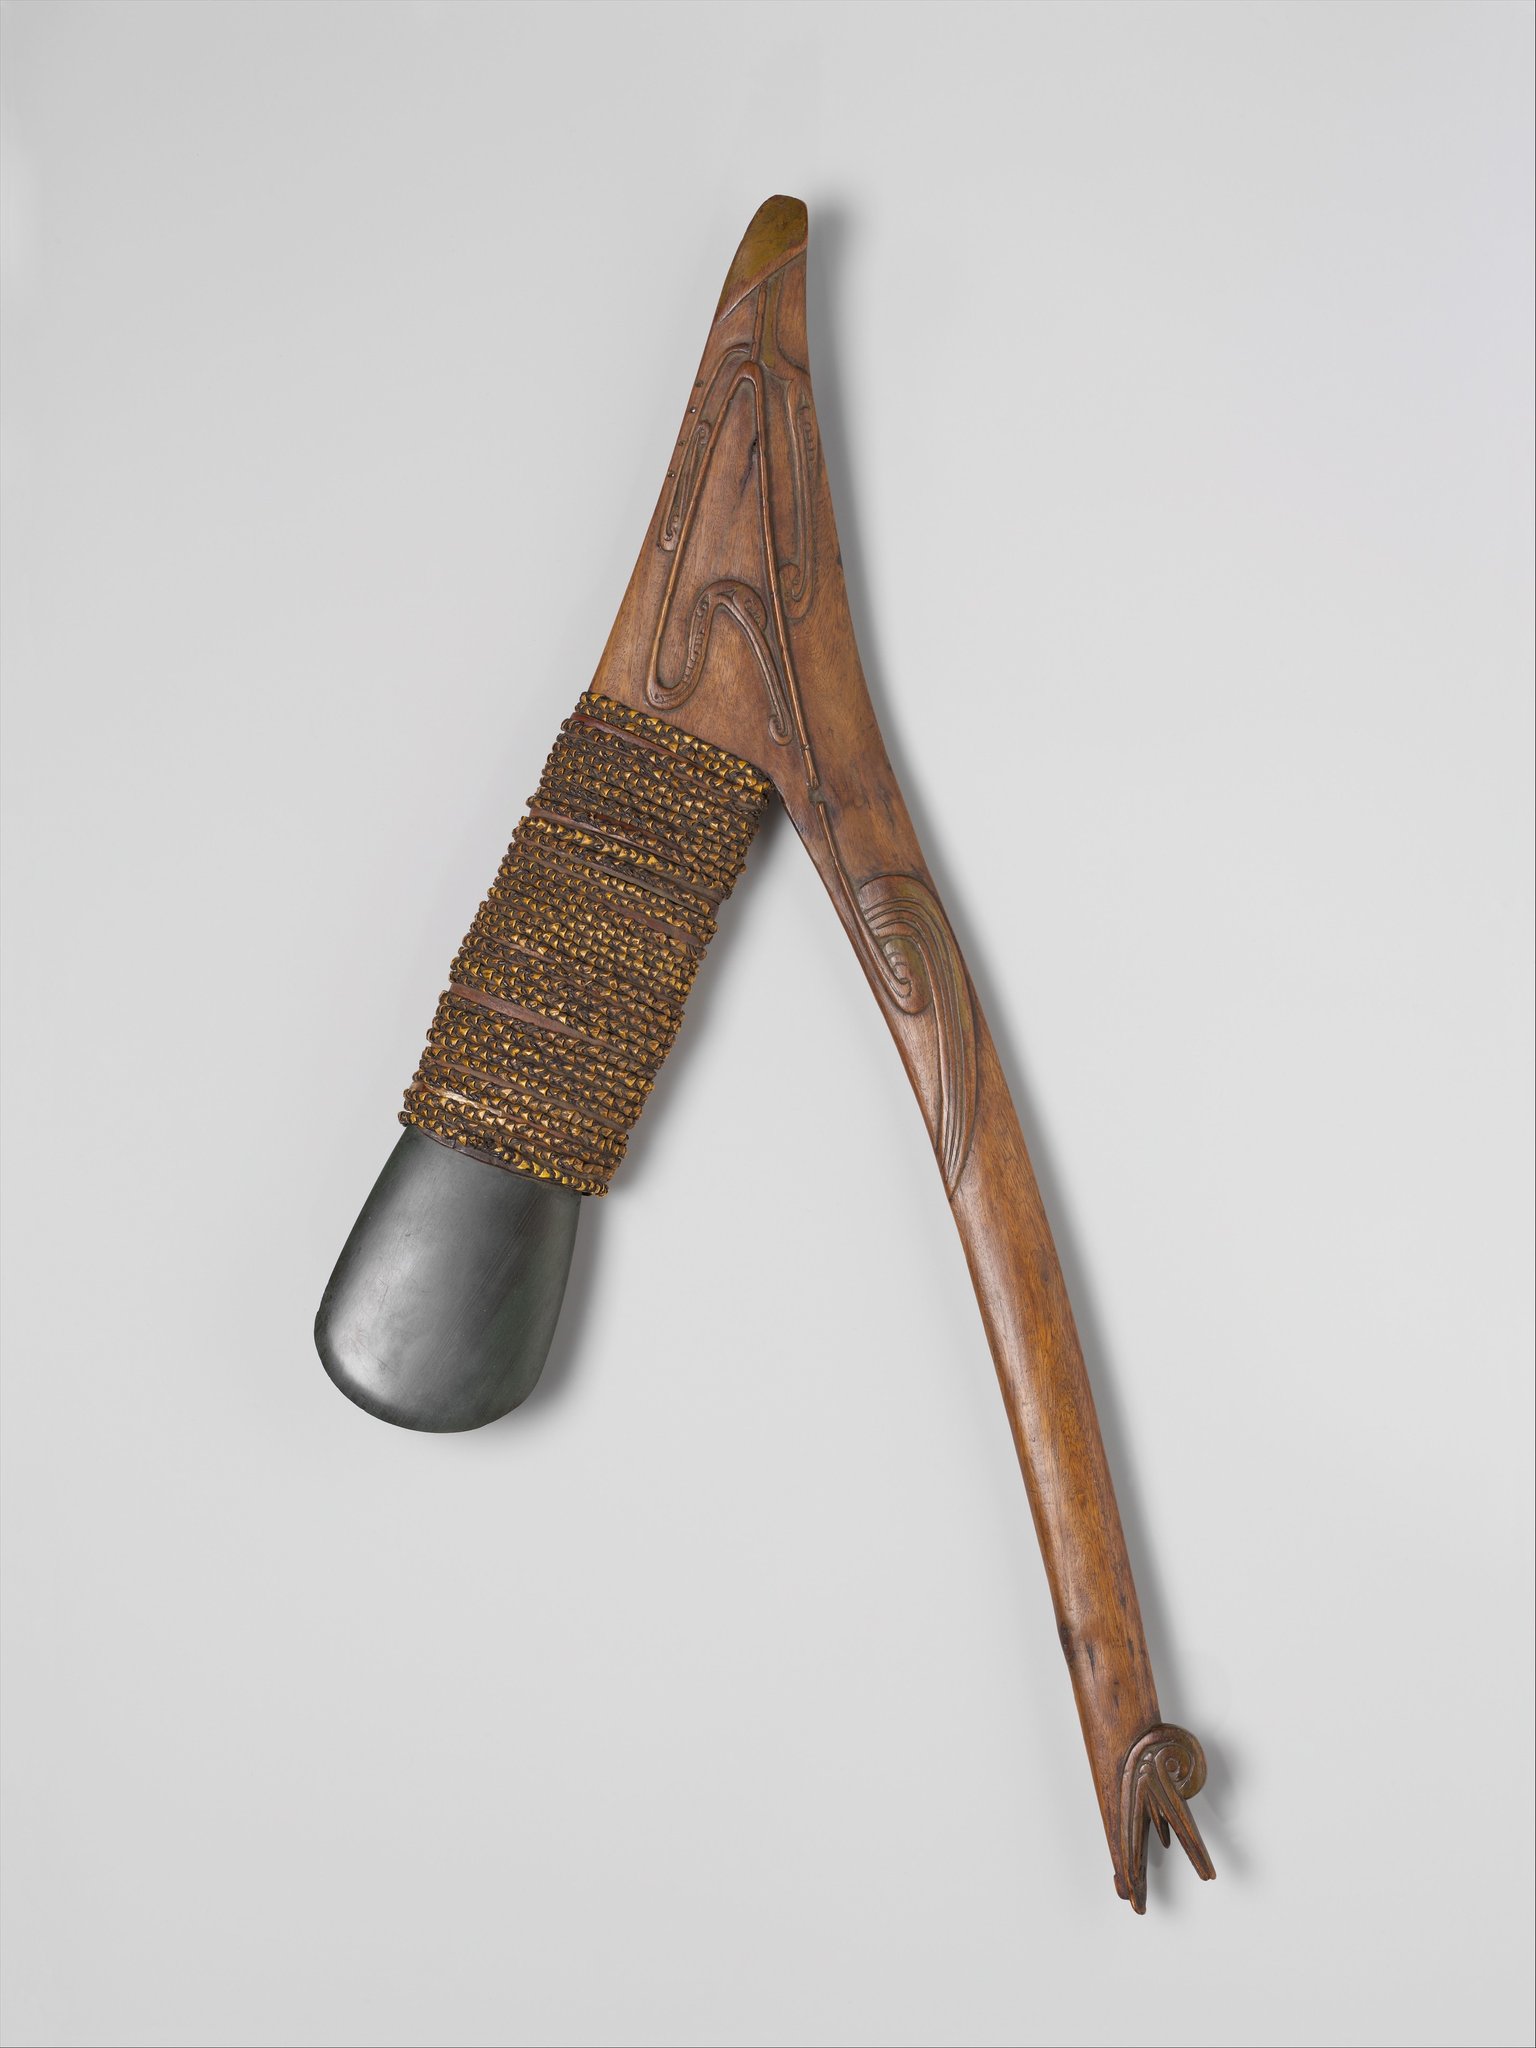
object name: axe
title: Ceremonial Axe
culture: massim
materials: fiber, stone, wood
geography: papua new guinea